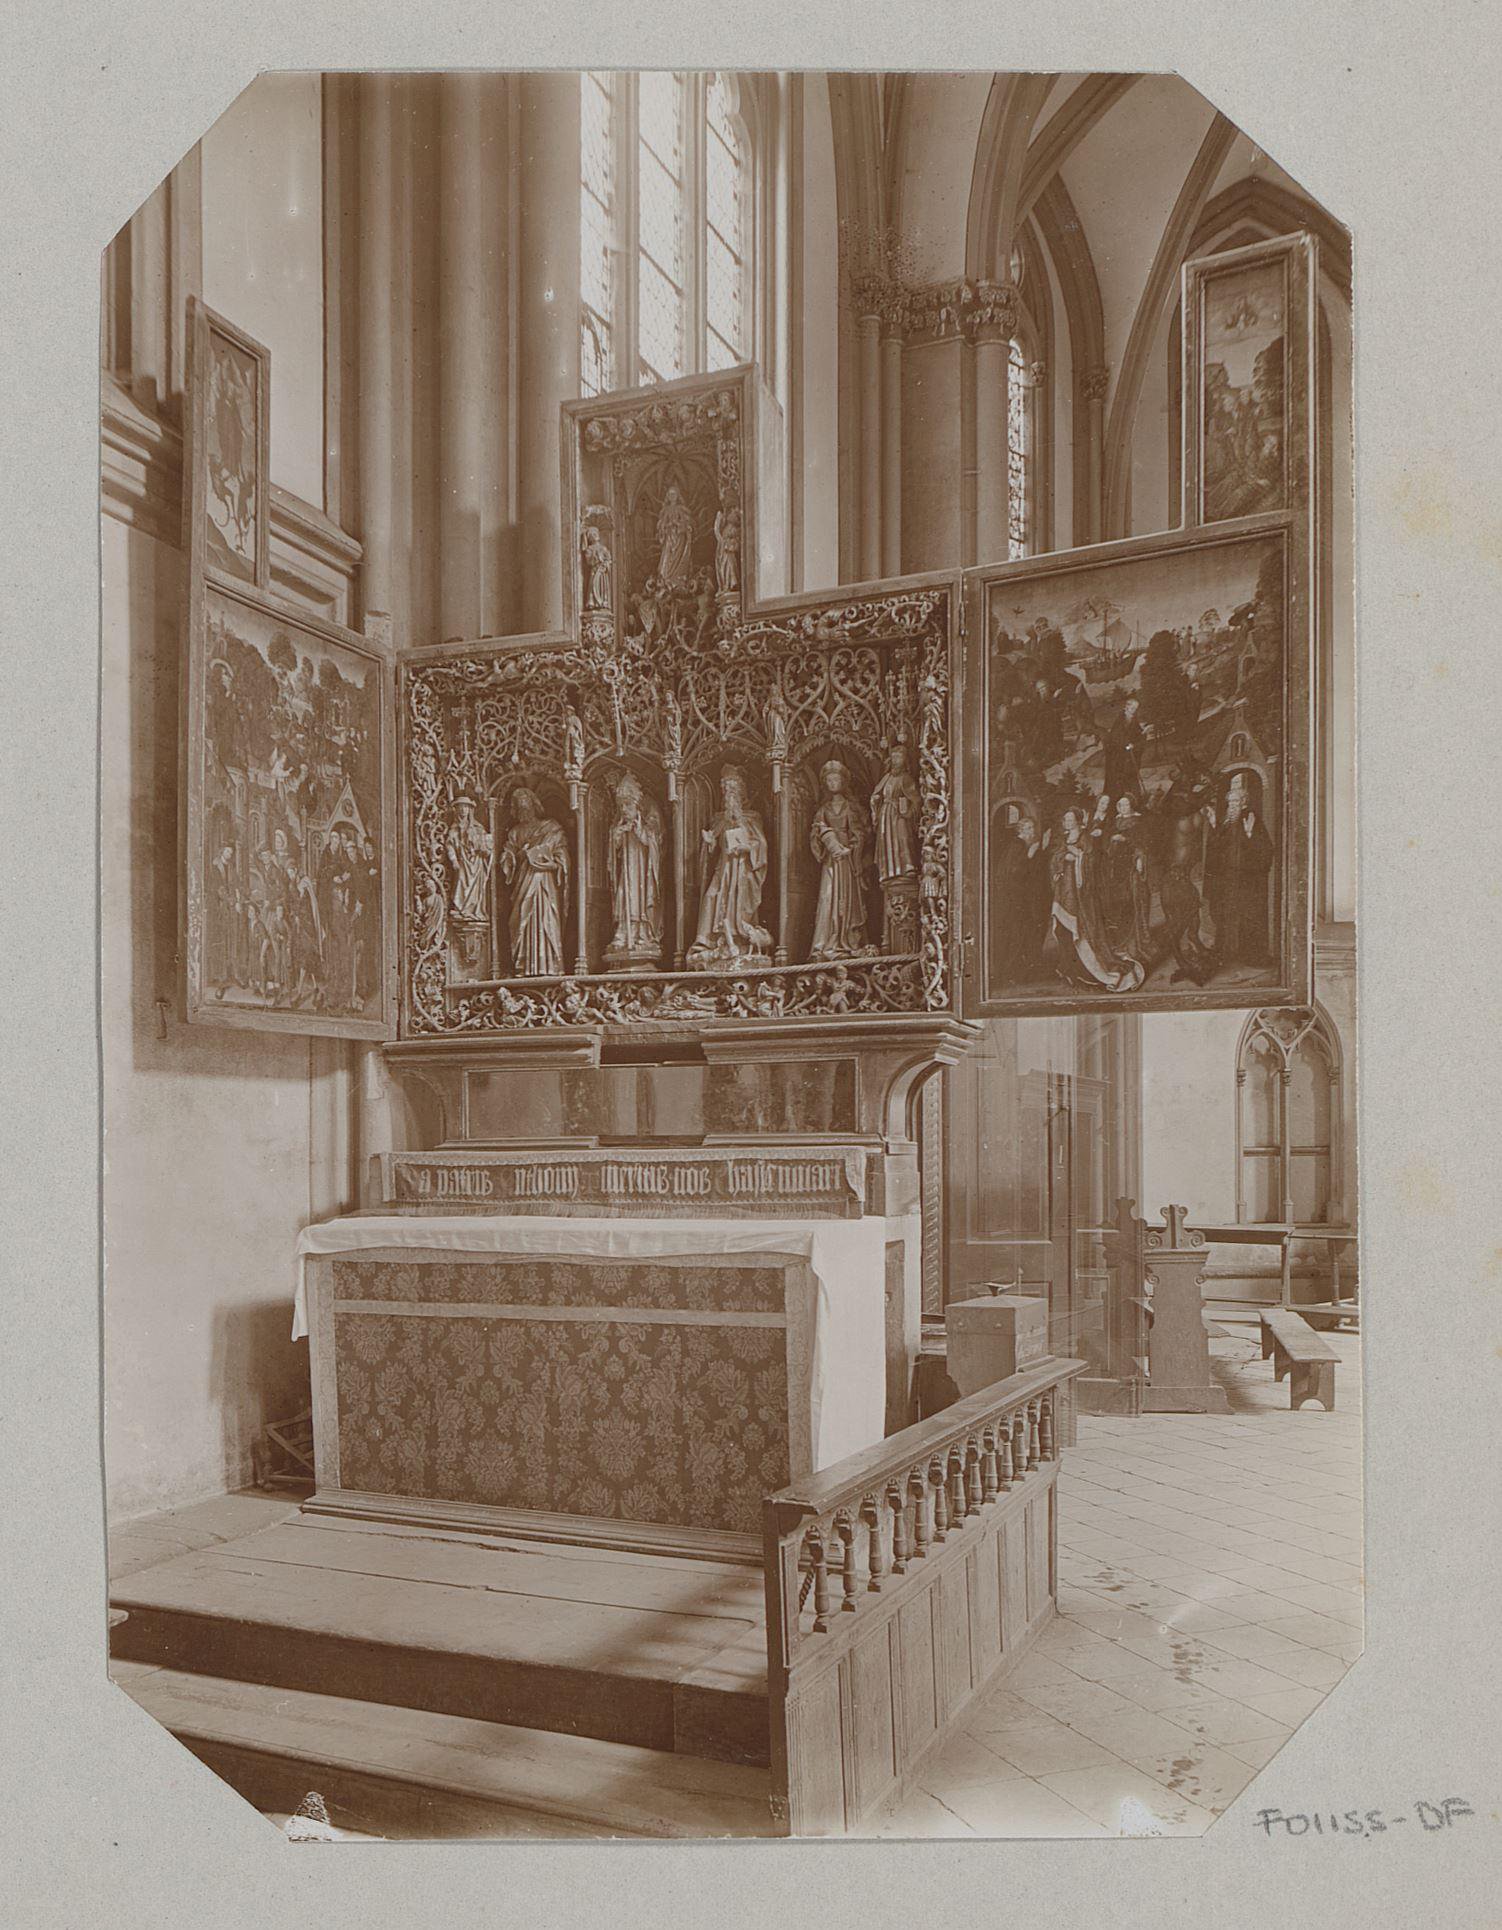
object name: album leaf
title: Altaar in de Dom van Xanten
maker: Anonymous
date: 1890-1902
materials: photographic support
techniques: collodion silver print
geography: xanten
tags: altar with altar-piece